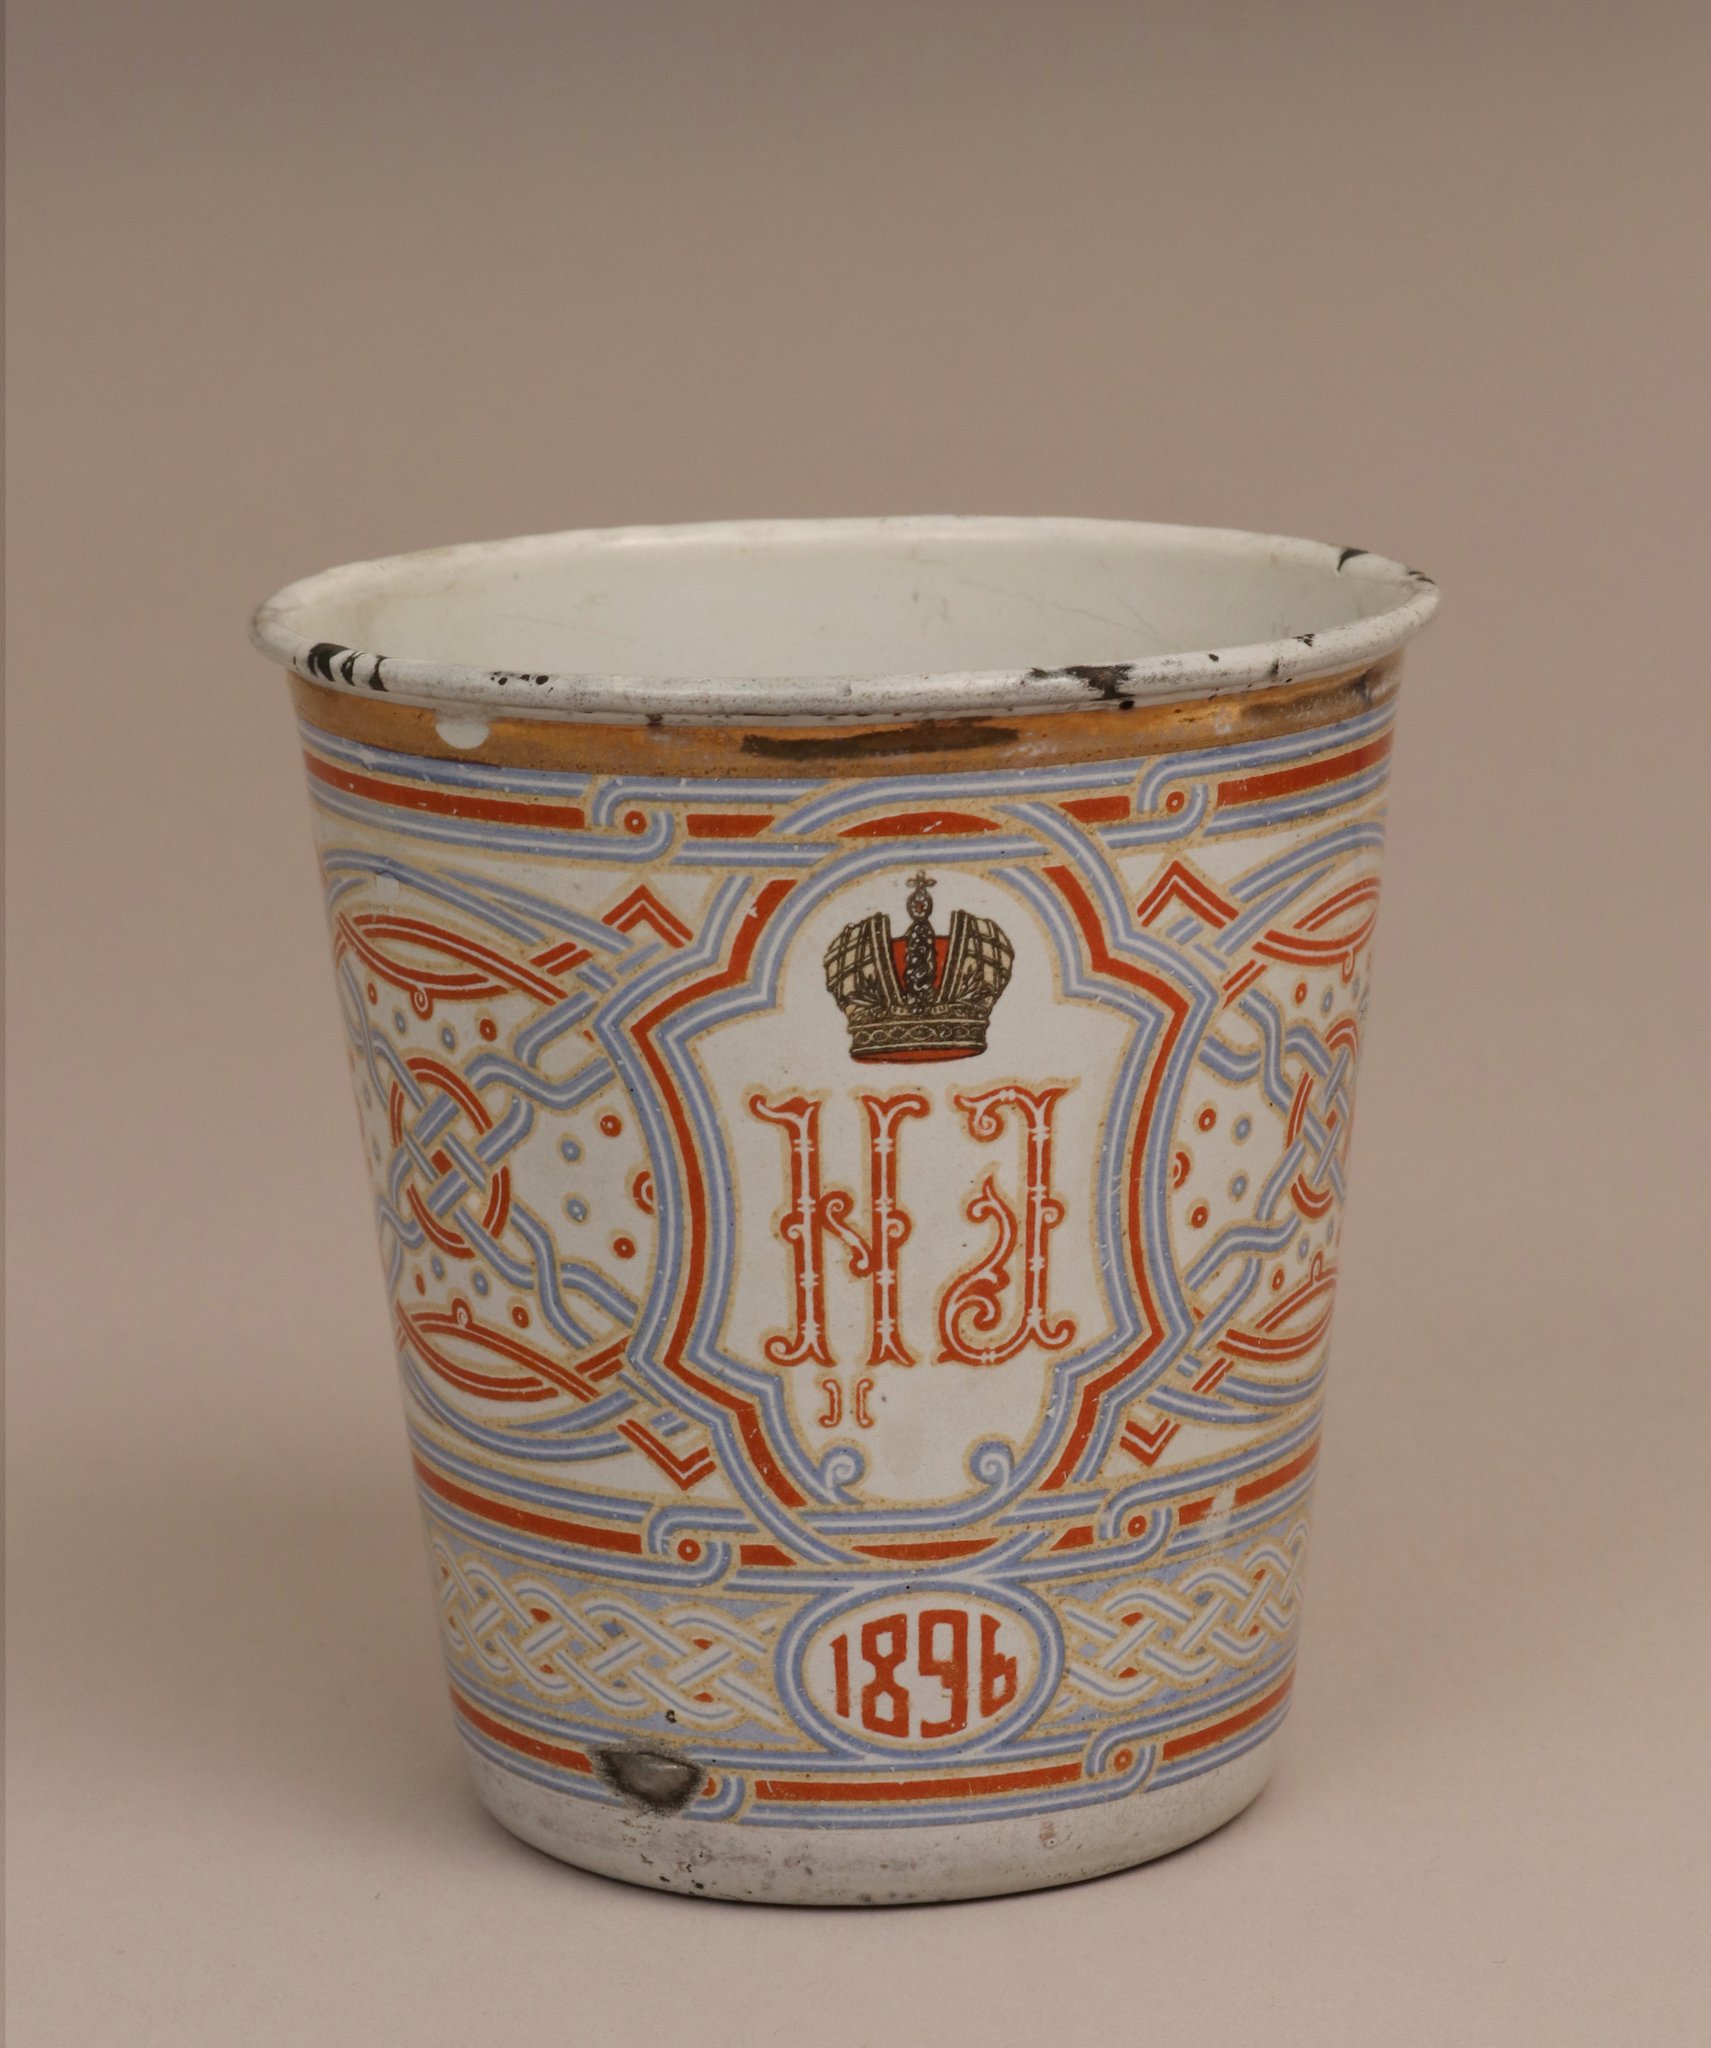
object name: beaker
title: Coronation beaker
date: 1896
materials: copper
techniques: enamel